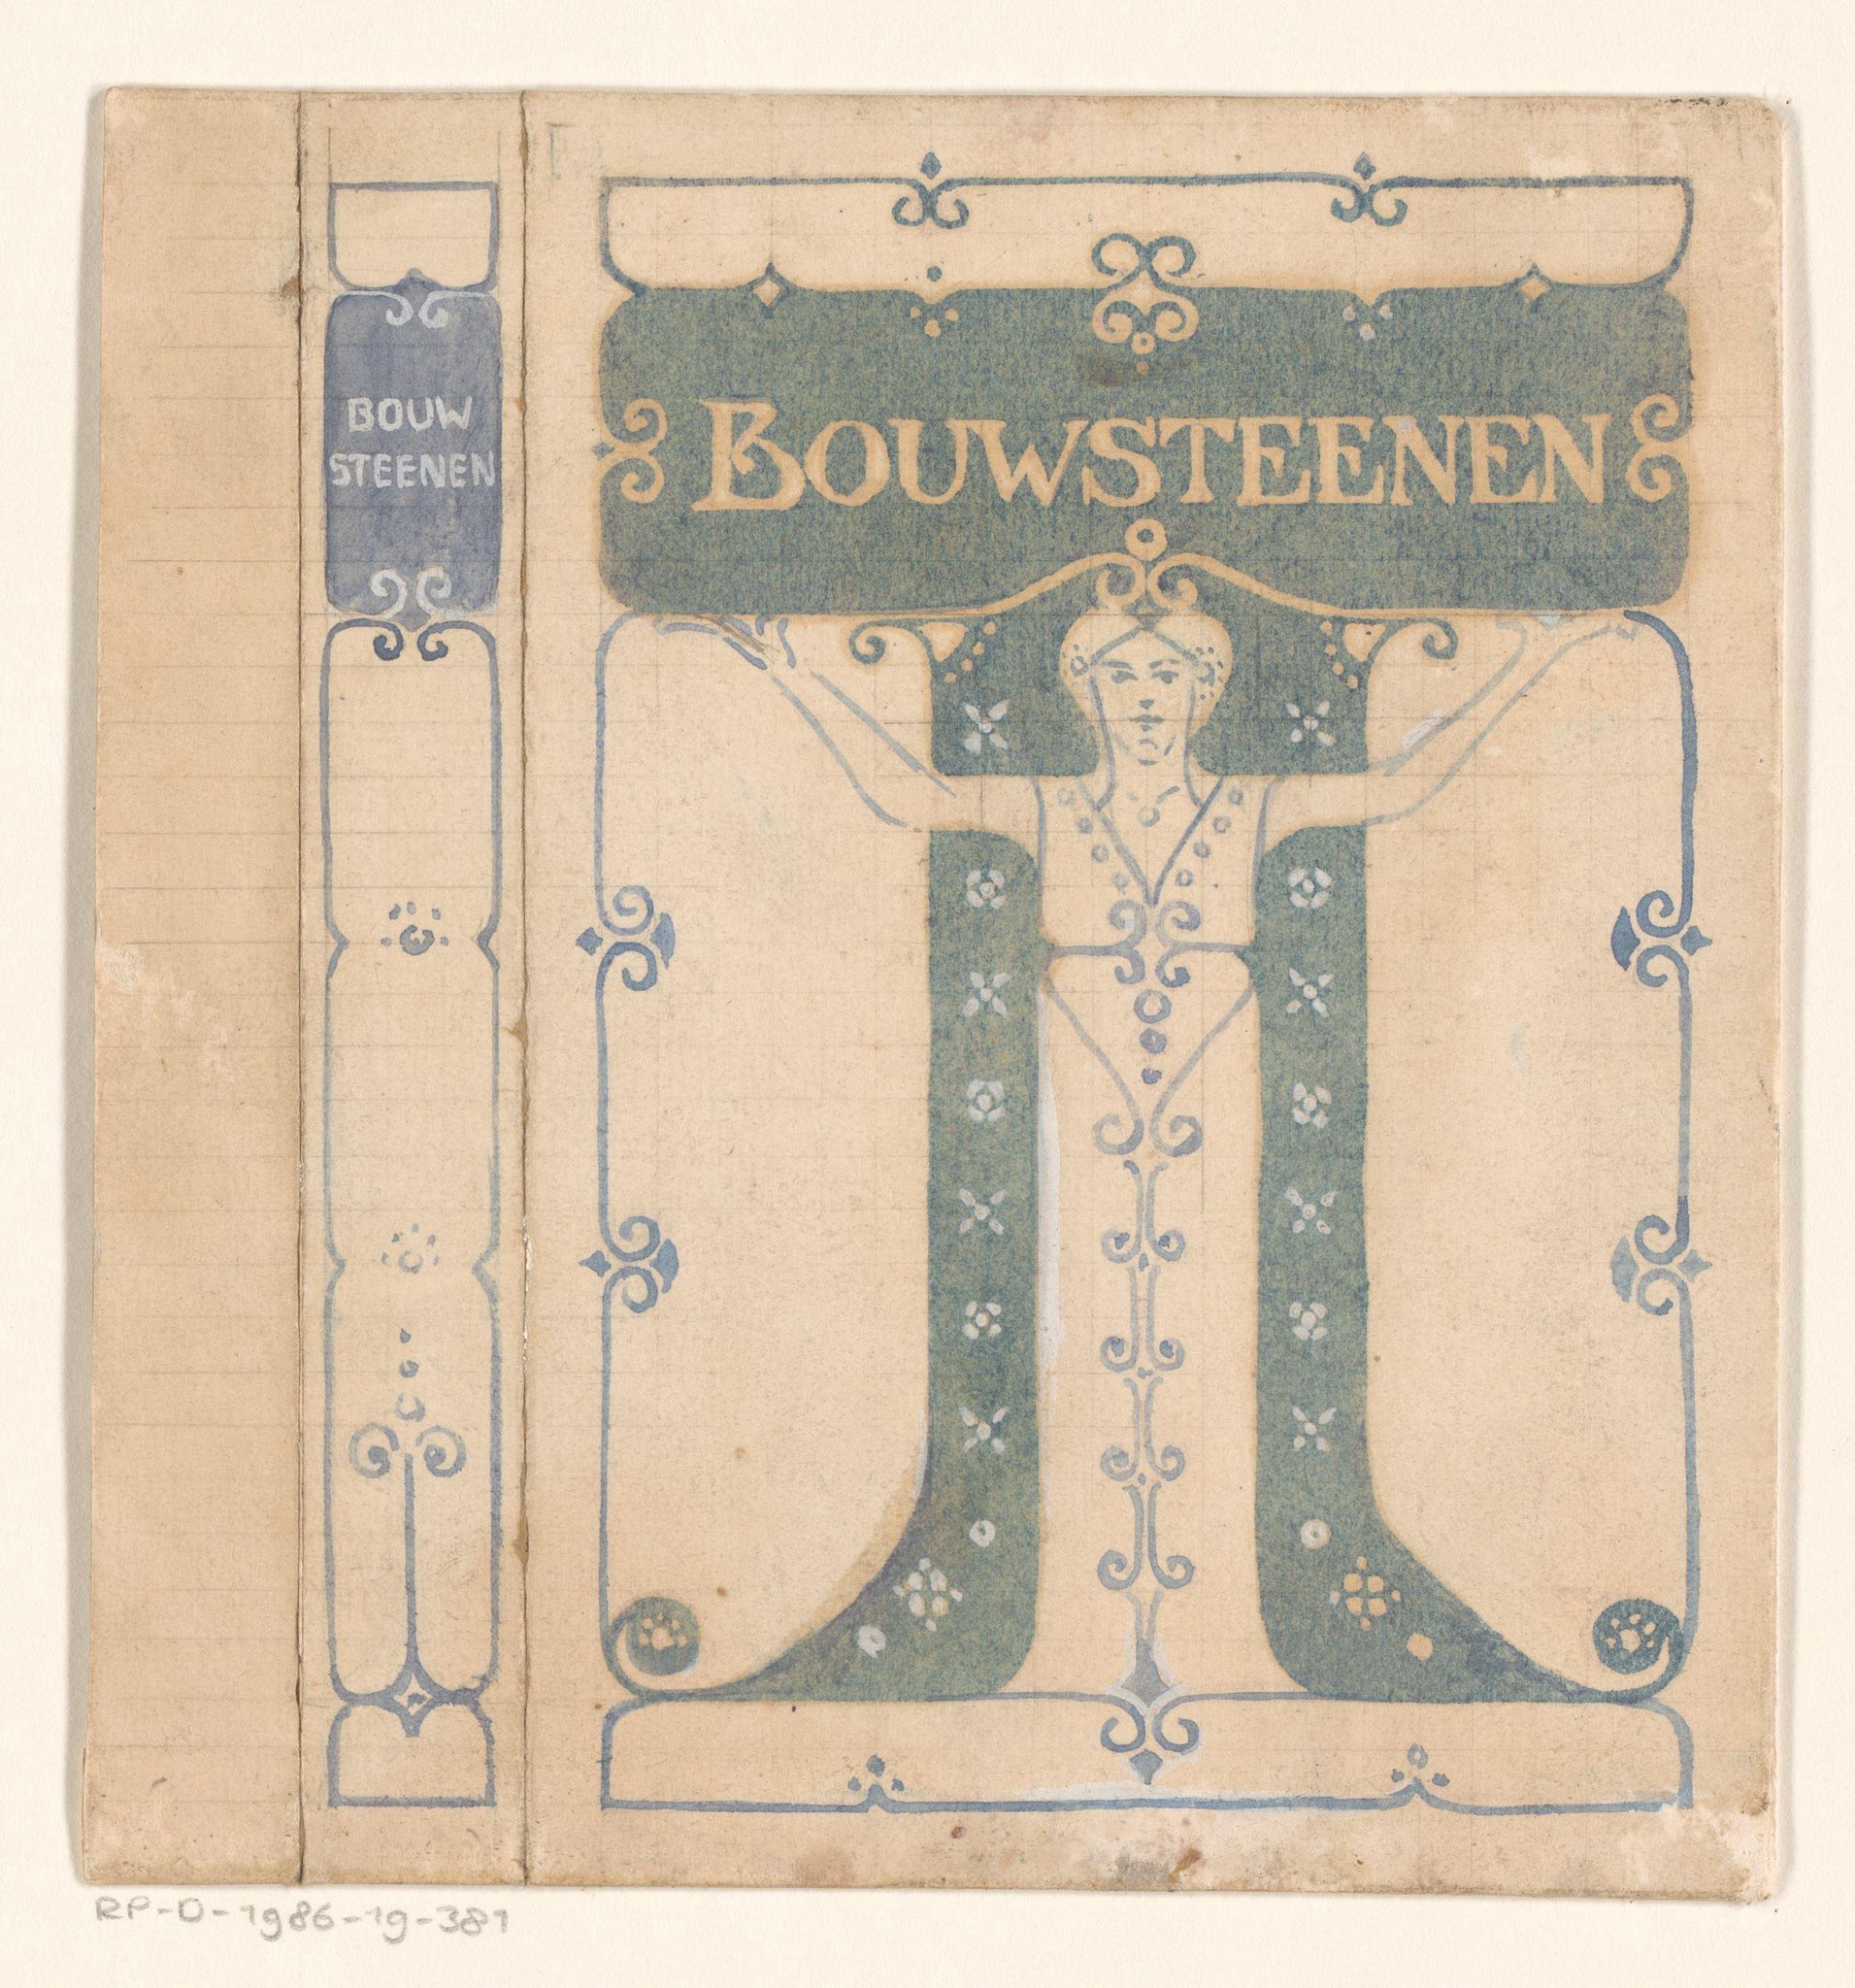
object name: drawing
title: Bandontwerp voor: P. de Vledder. Bouwsteenen, 1908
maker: reinier willem petrus de vries (1874-1953)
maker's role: draughtsman, print maker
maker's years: 1874-1953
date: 1908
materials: cardboard, paint, ink, pencil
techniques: brush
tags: arm raised upward, standing figure - aa - female human figure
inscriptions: collector's mark: ‘R:MVS.’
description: Bandontwerp voor: Vledder, P. de. Bouwsteenen. Keur van goede gedachten tot opbouw van ons geestelijk leven. Baarn: Hollandia-Drukkerij, 1908.